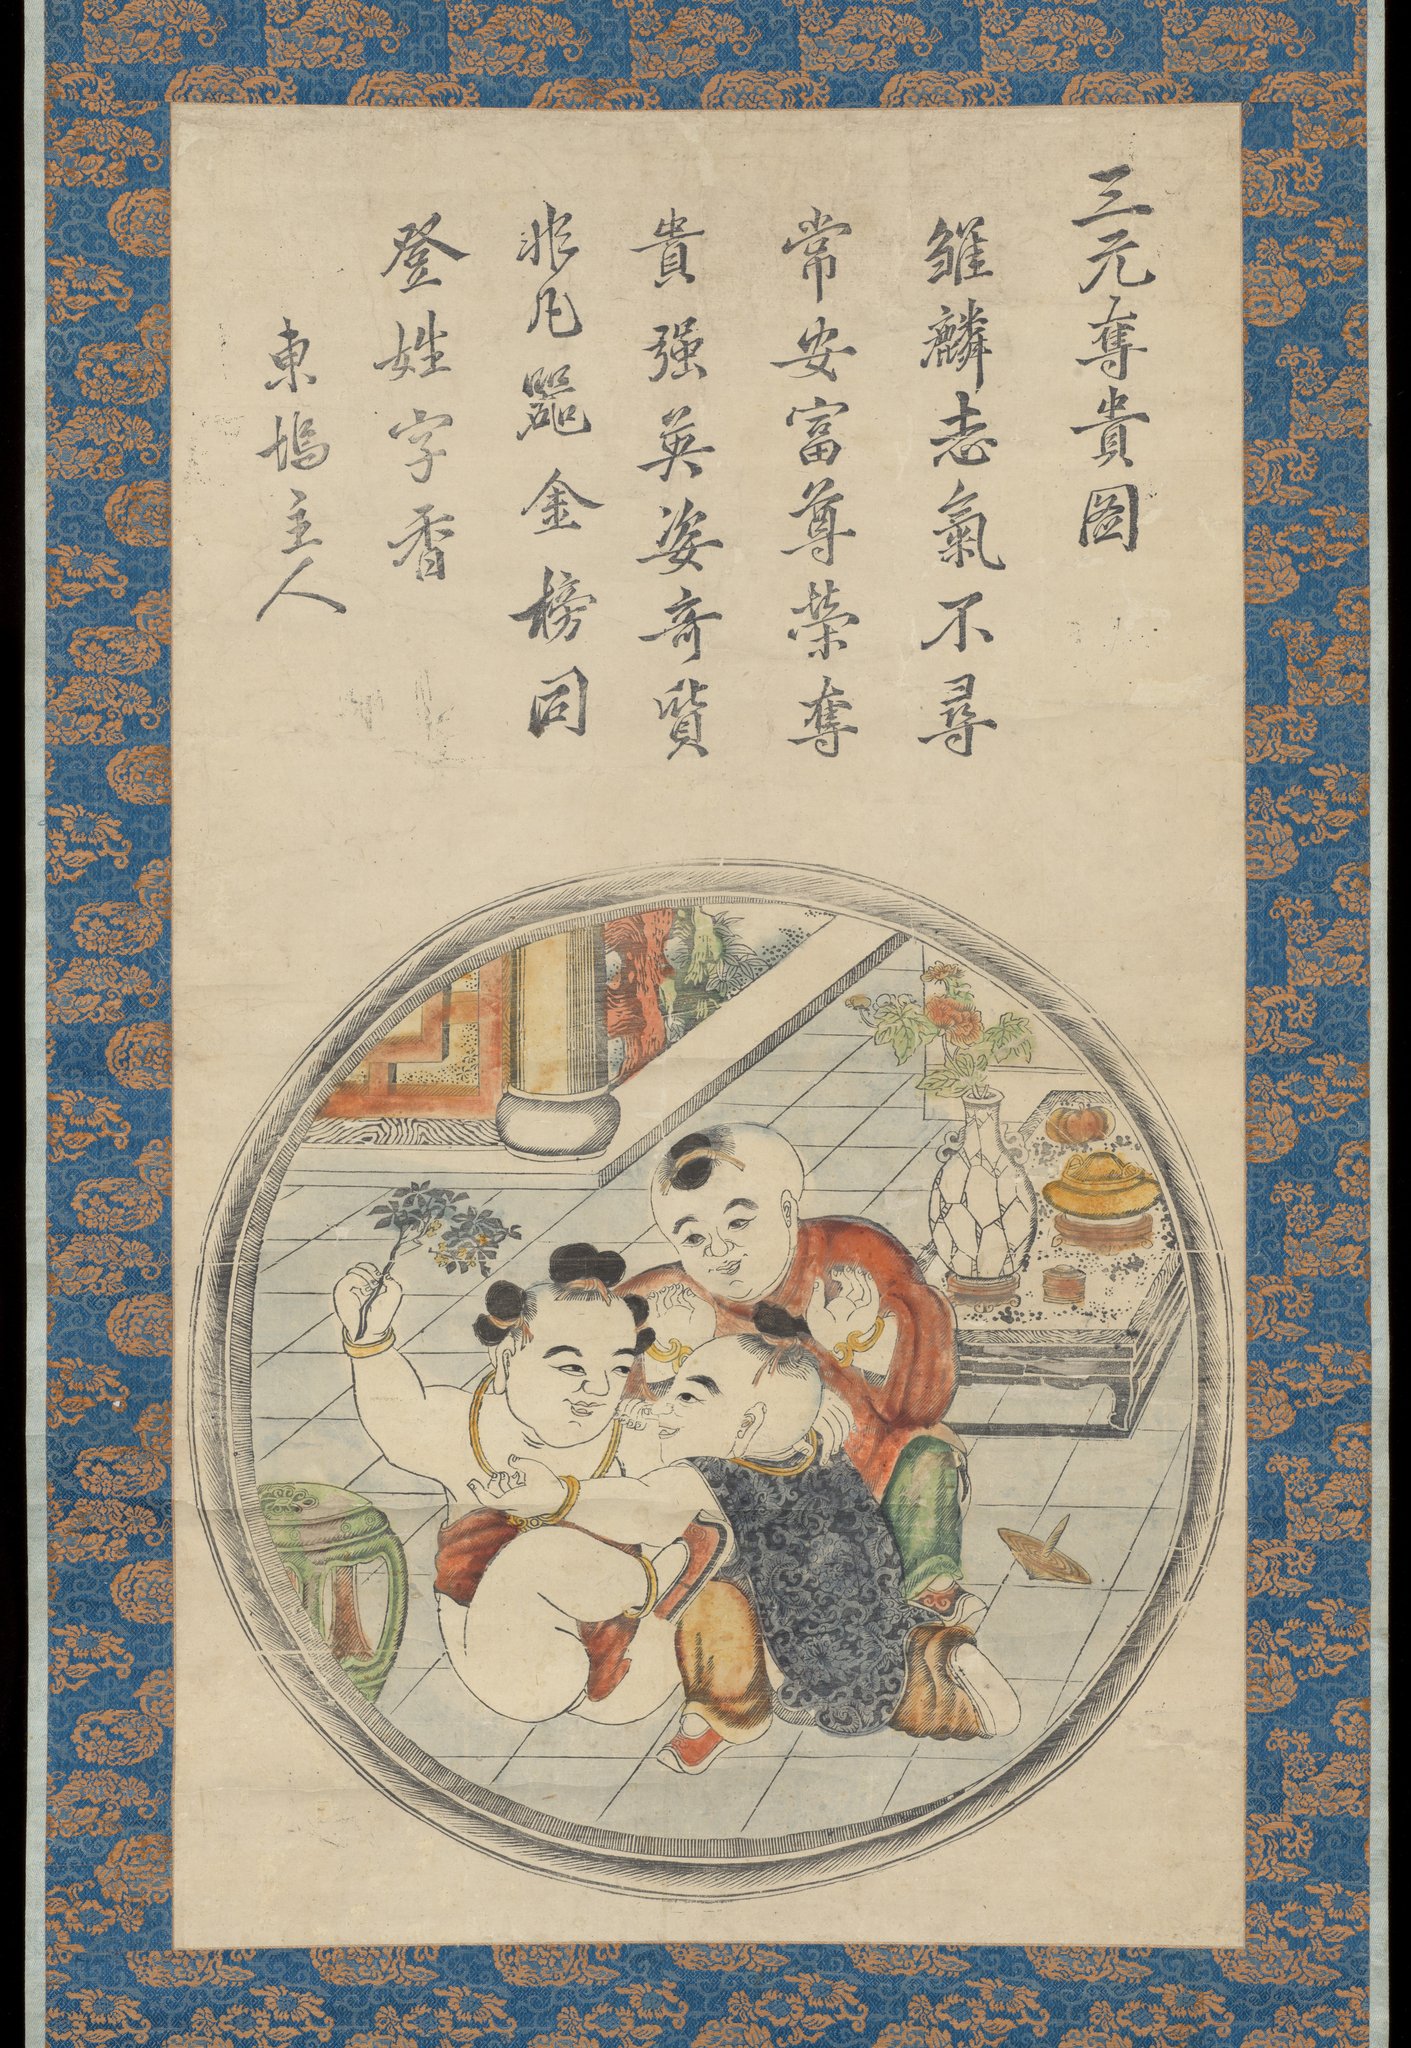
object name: print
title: Three Boys Grabbing Nobility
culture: chinese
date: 1736-1795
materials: ink, paper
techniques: hand coloring, woodblock print